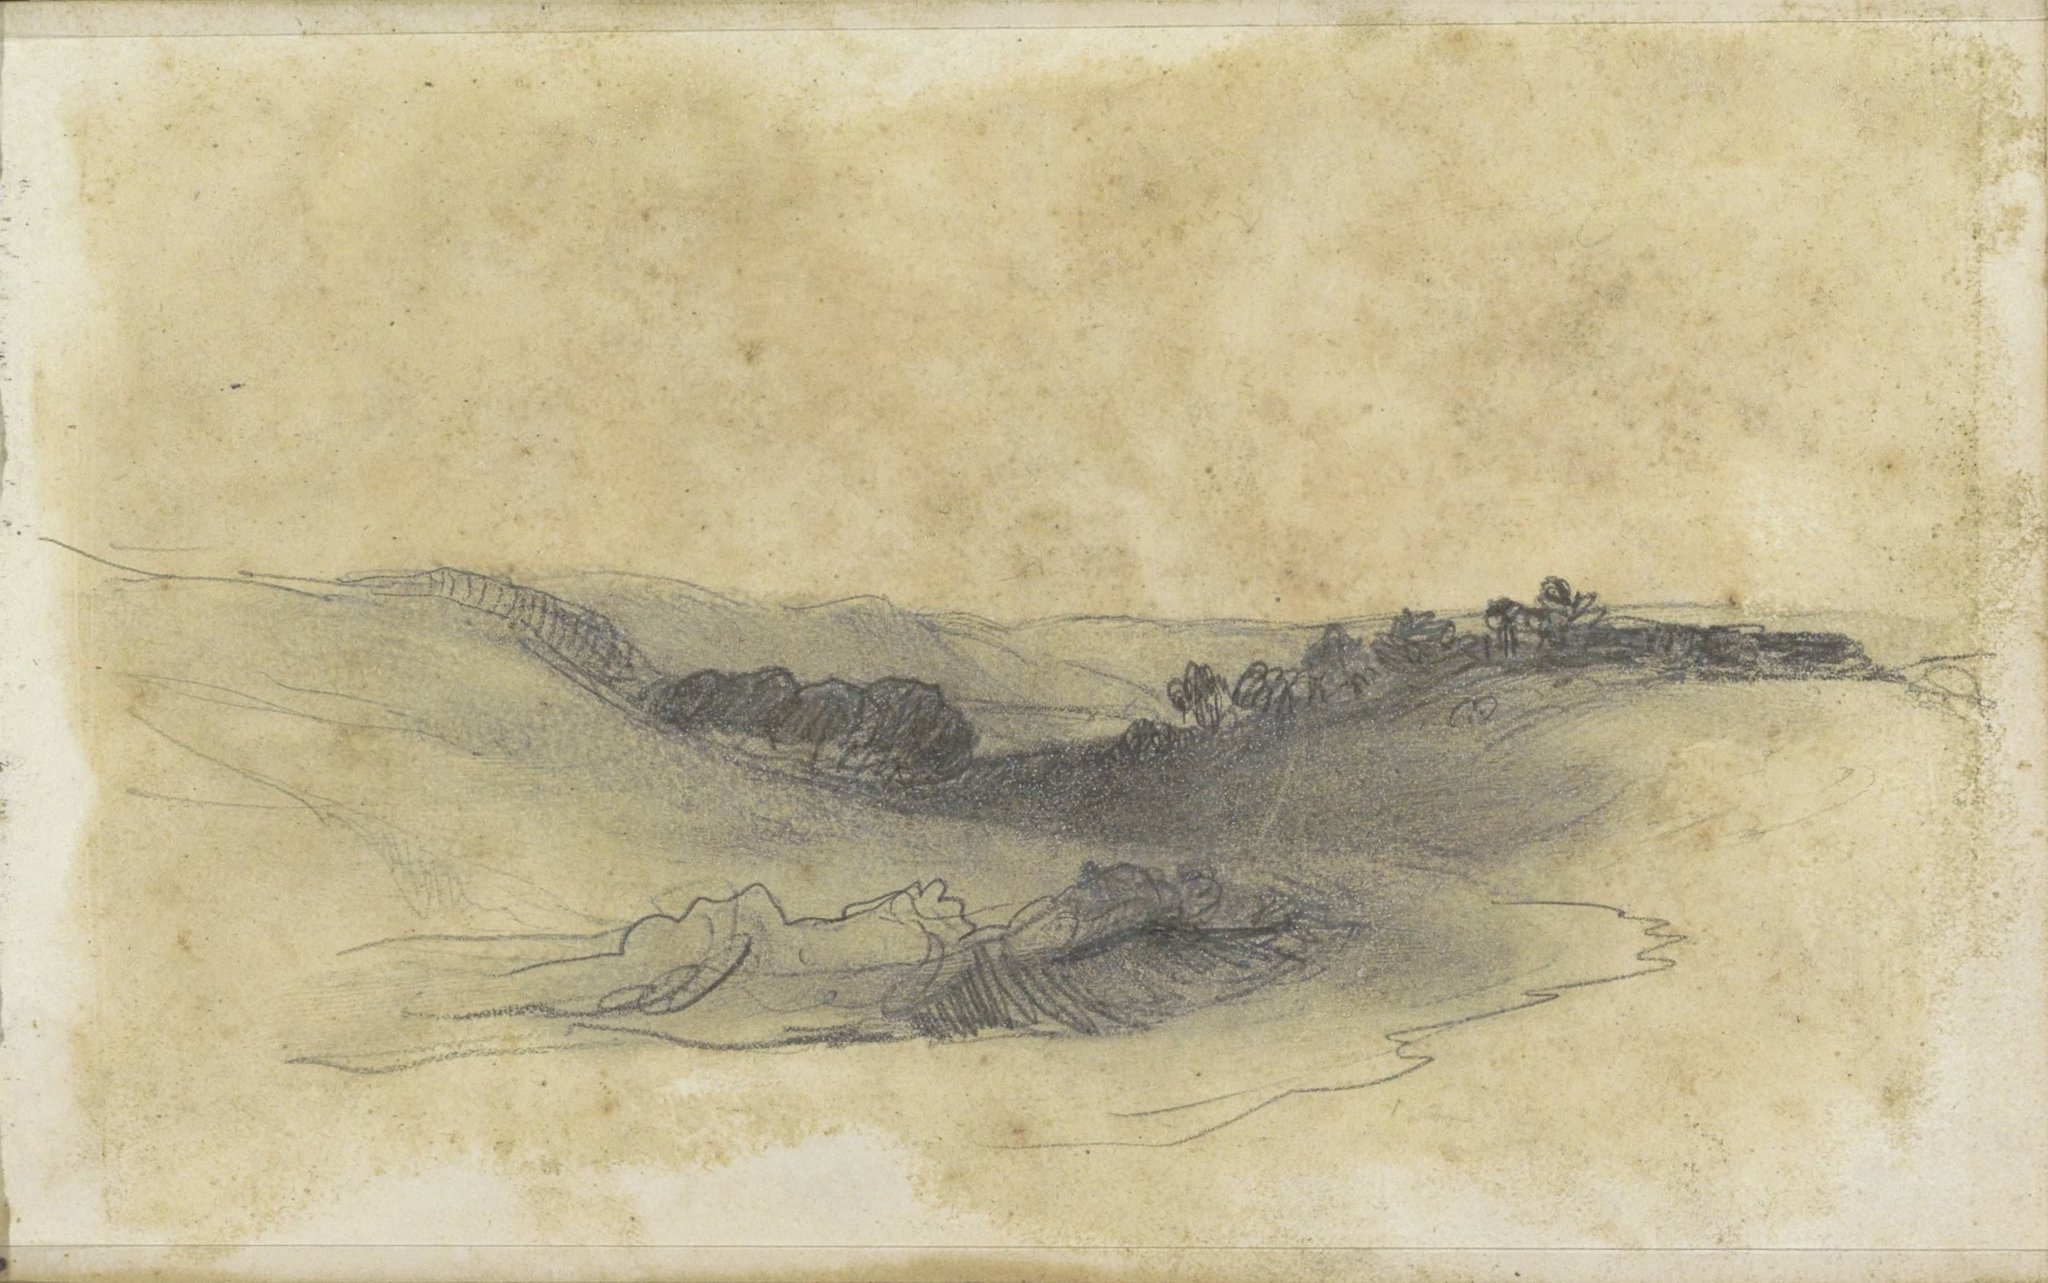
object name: sketchbook leaf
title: Heuvellandschap met bomen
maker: johannes tavenraat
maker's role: draughtsman, painter, print maker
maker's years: 1809-1881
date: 1843-1844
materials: paper, pencil, watercolor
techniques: brush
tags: low hill country, trees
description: Blad 3 recto uit een schetsboek met 38 bladen.